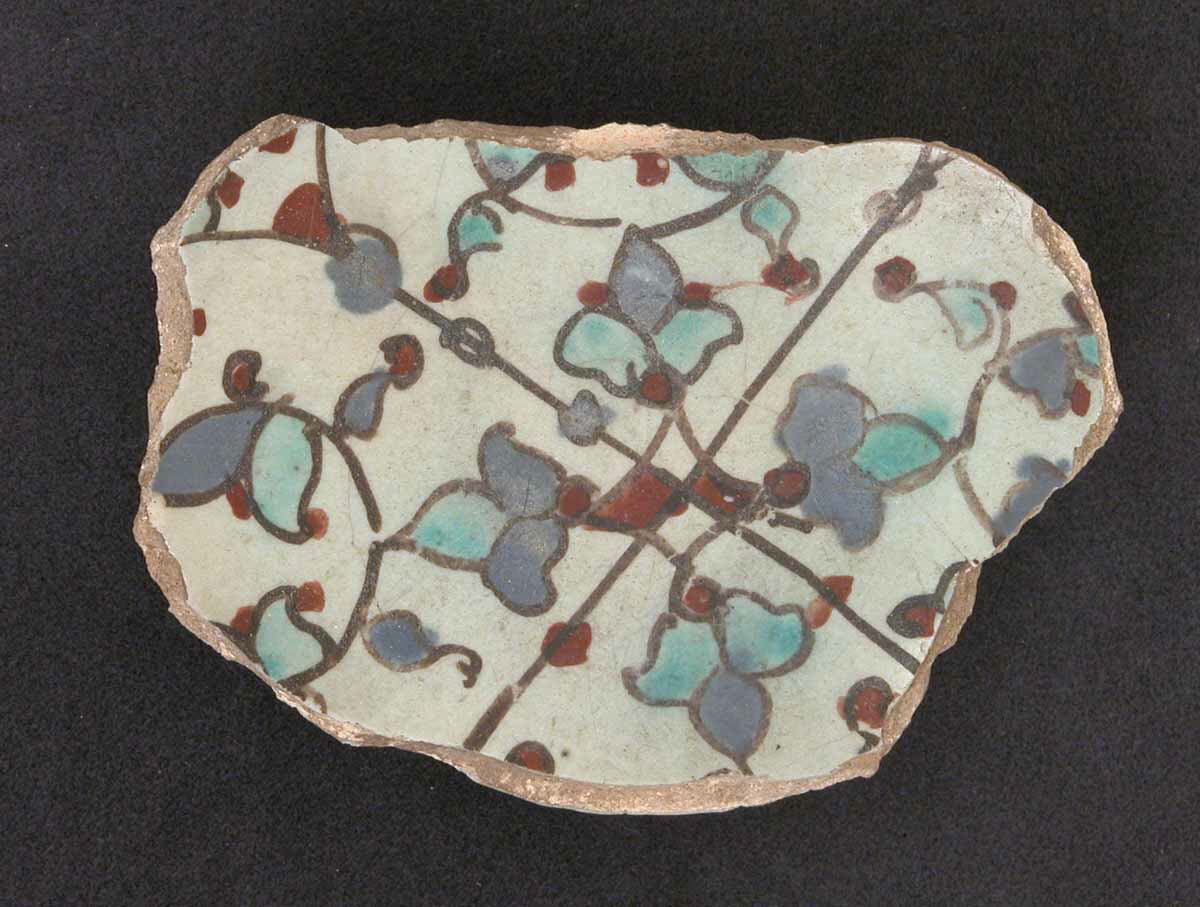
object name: fragment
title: Fragment of a Bowl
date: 1201-1400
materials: stonepaste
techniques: painting, underglaze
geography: syria